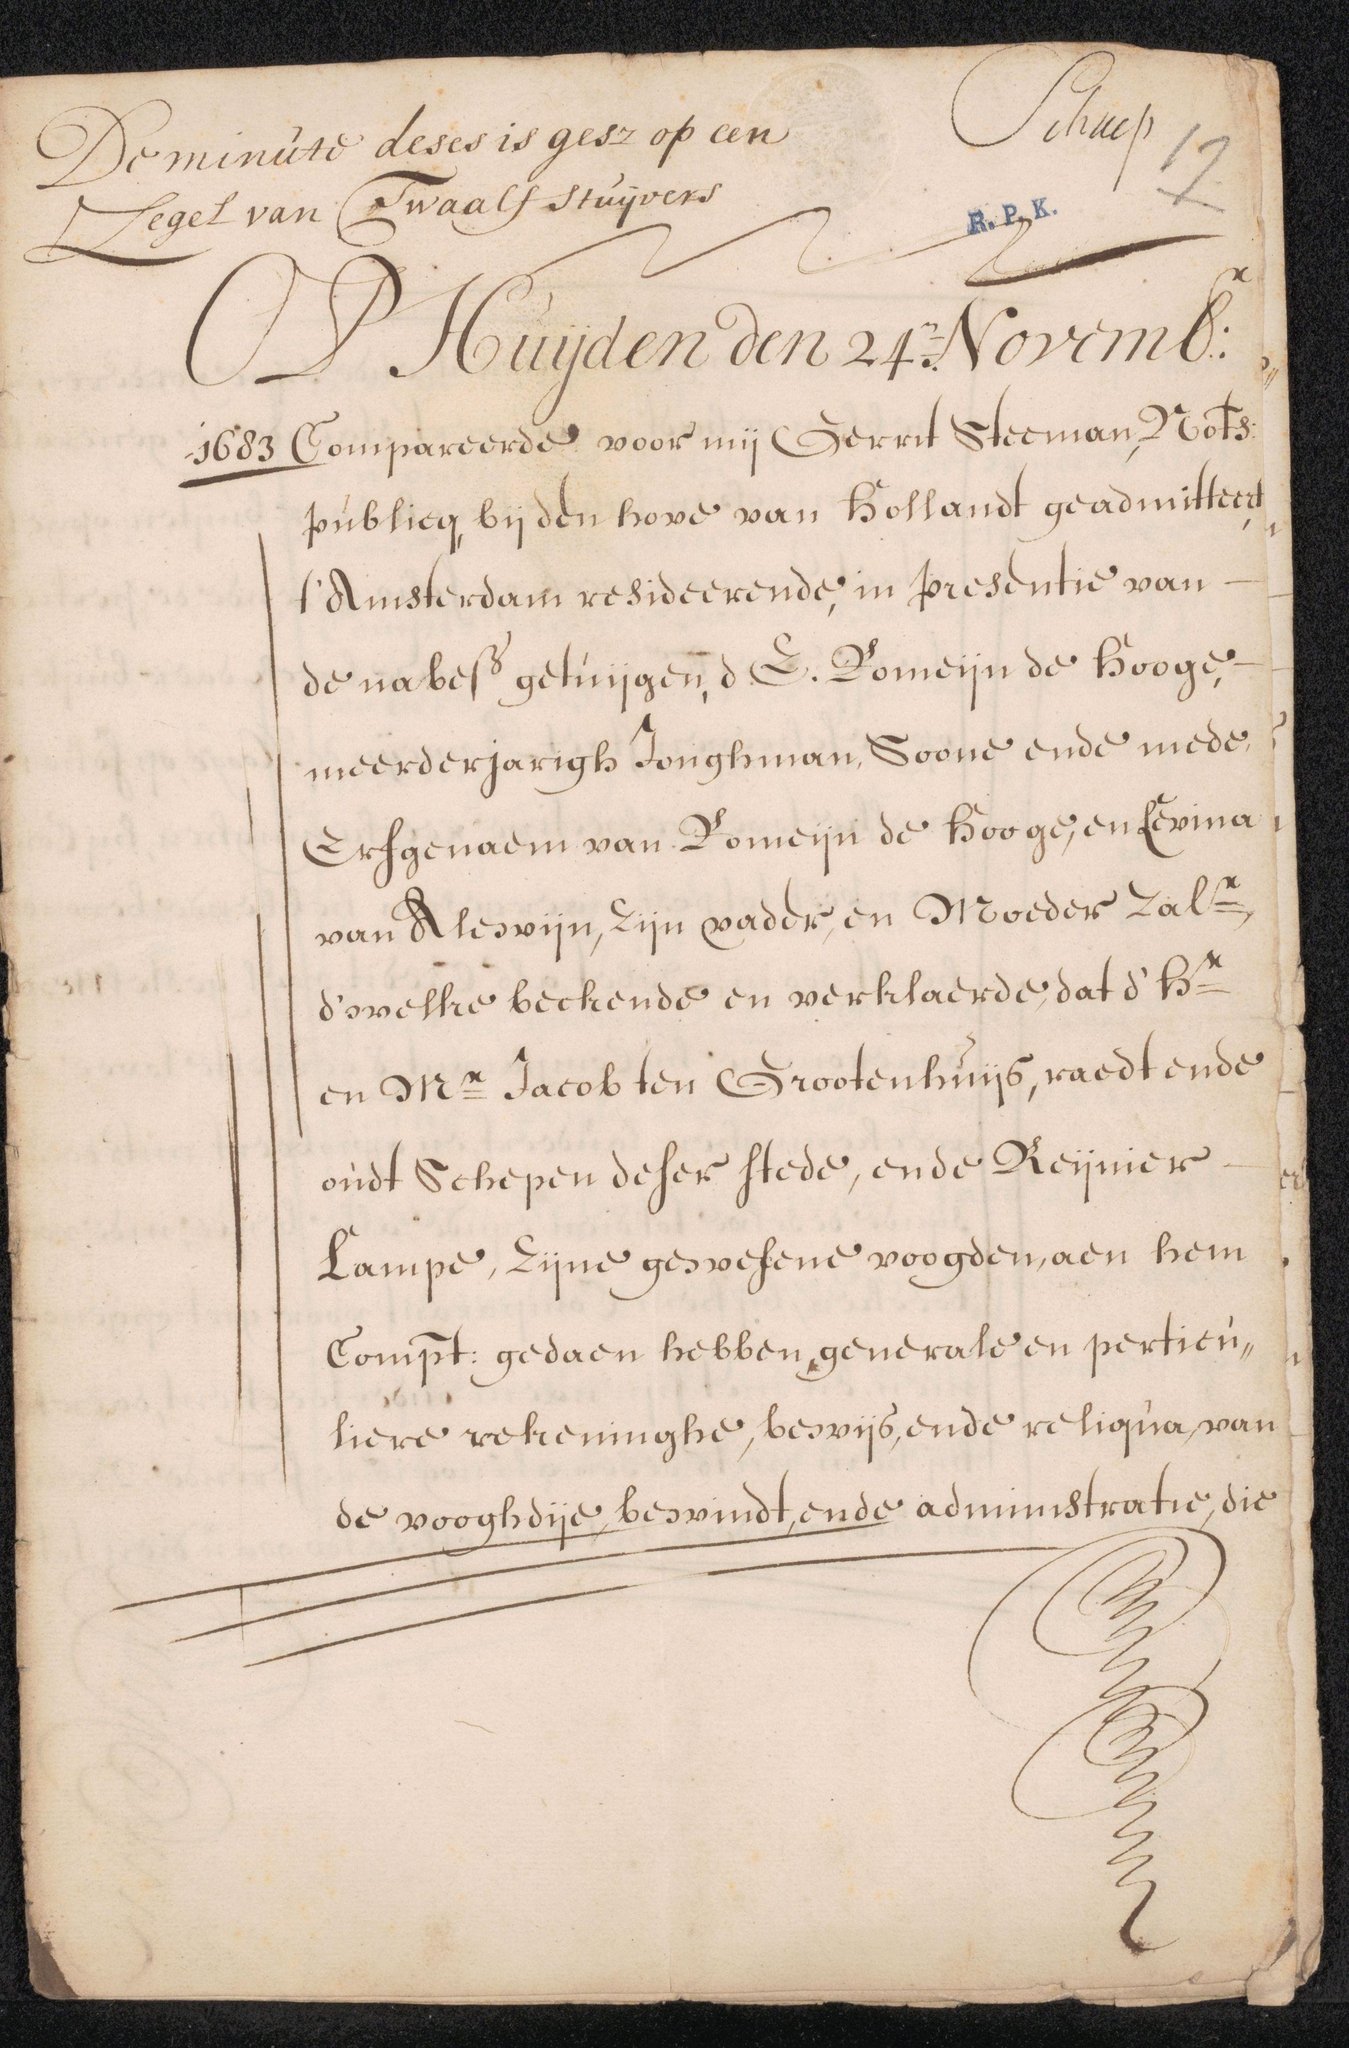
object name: document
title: Notariële akte met betrekking tot Romeyn de Hooghe (1655-1704) en zijn voormalige voogden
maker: gerrit steeman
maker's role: notaris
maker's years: -1698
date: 1683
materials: ink, paper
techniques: pen, writing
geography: amsterdam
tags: family life, money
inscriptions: seal, collector's mark: Lugt 2233, watermark